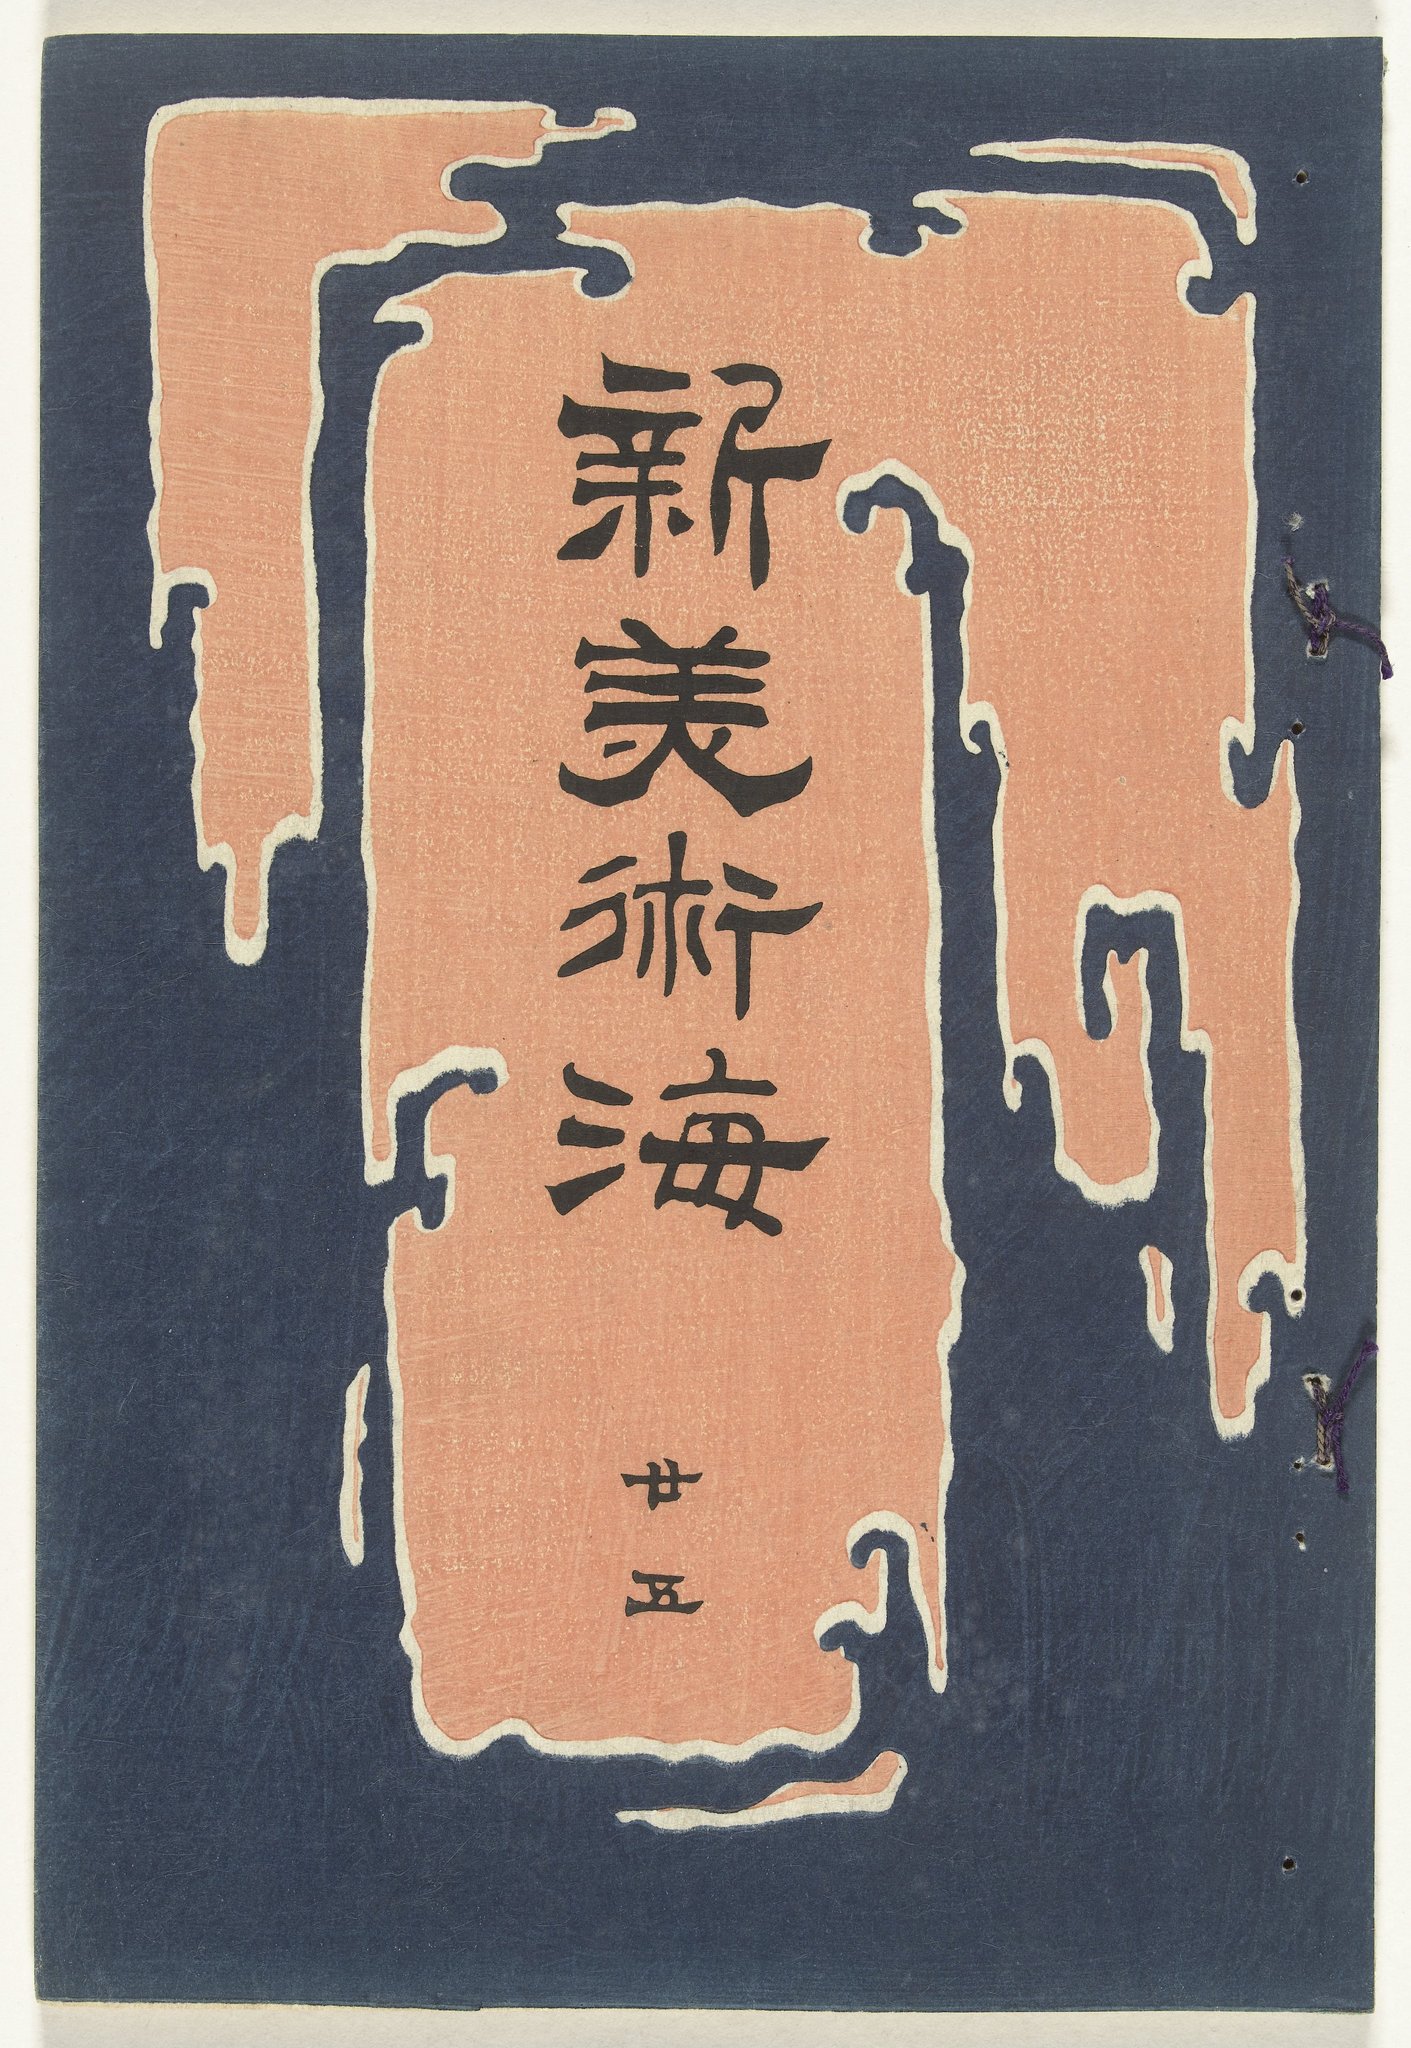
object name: book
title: Nieuwe zee der kunsten - 25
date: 1904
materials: gold powder, paper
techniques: woodcut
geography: kyoto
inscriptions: date